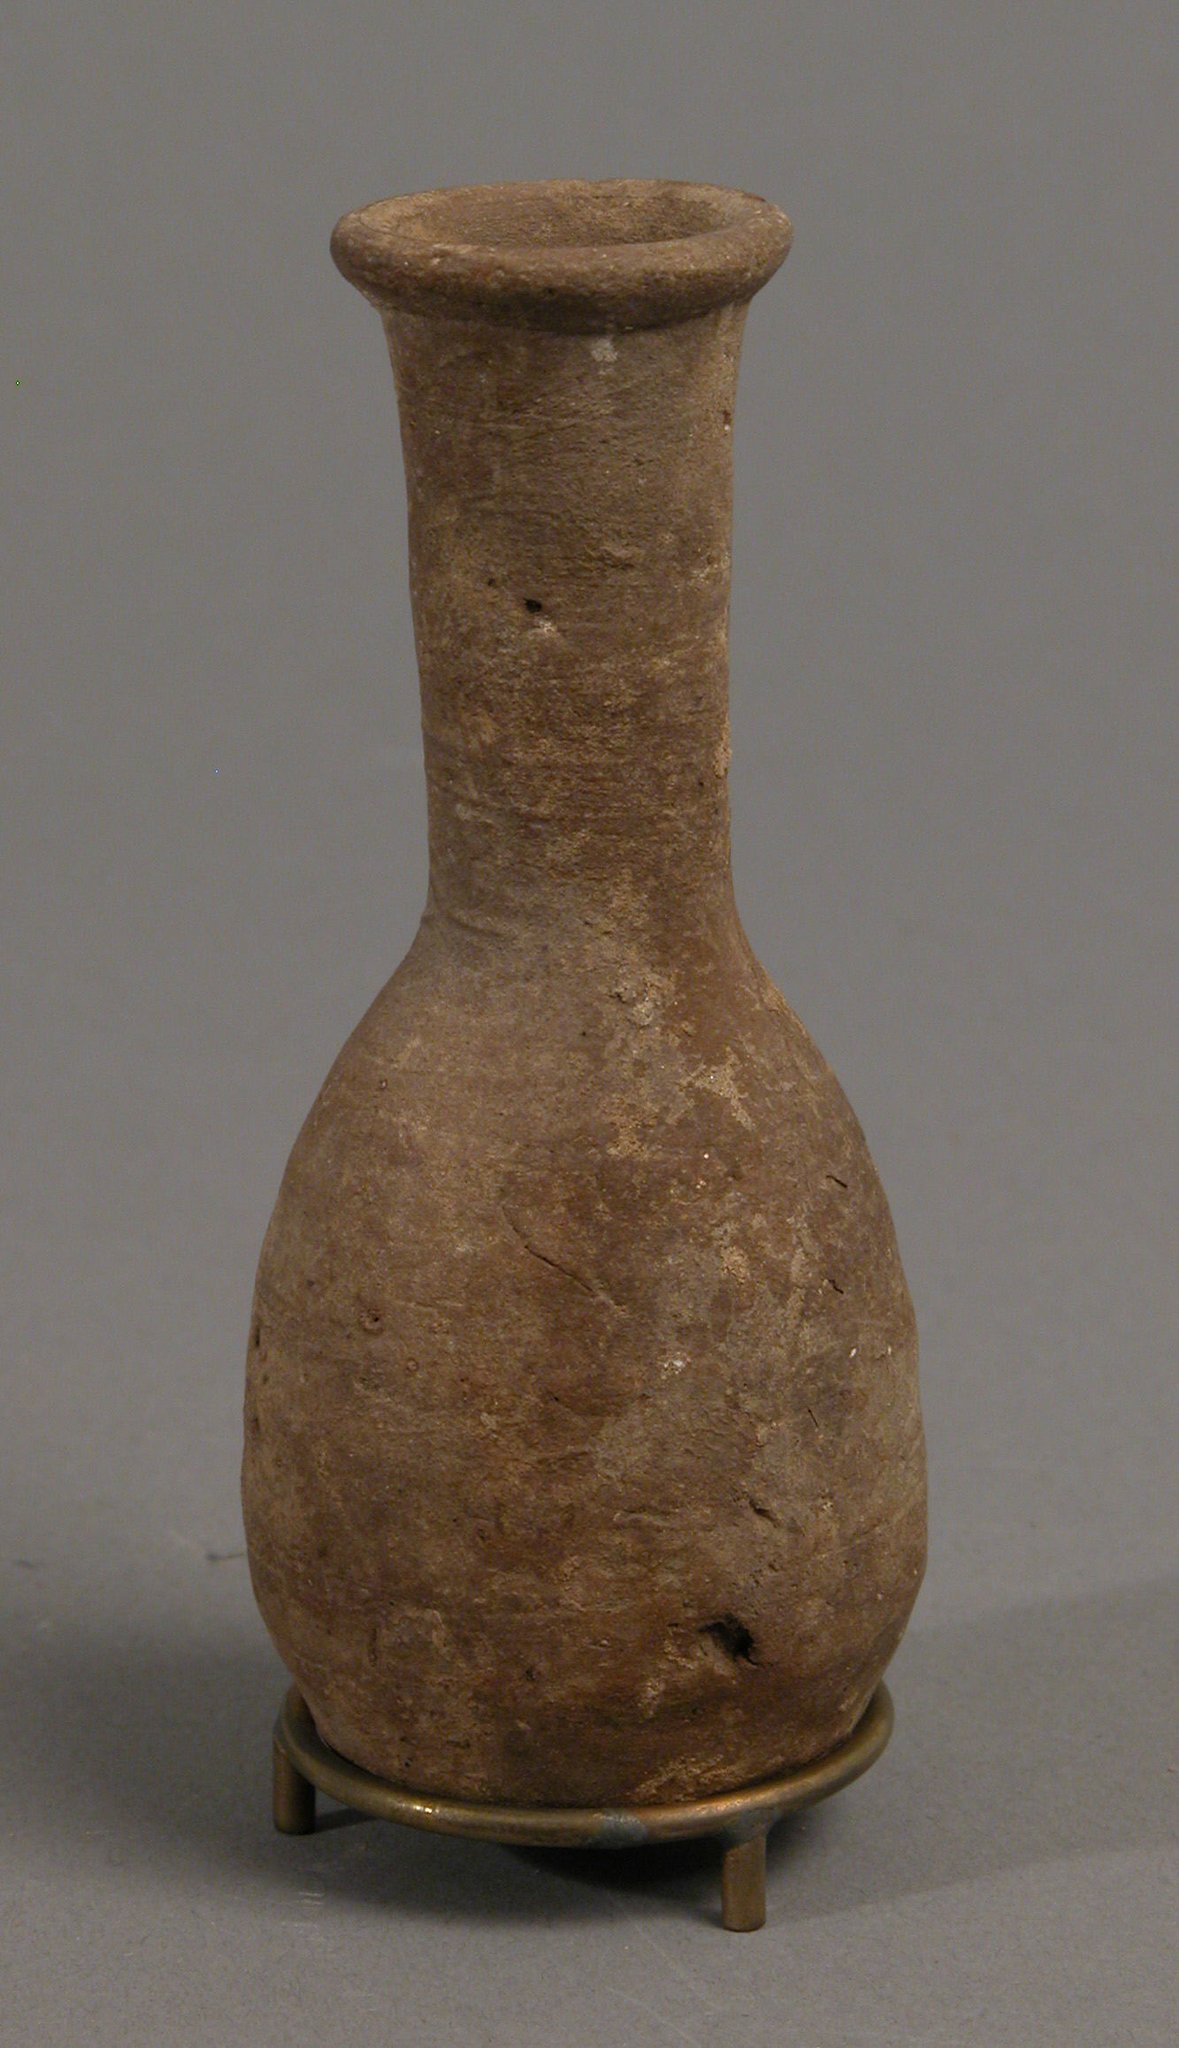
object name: pot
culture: coptic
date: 301-700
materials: earthenware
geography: egypt